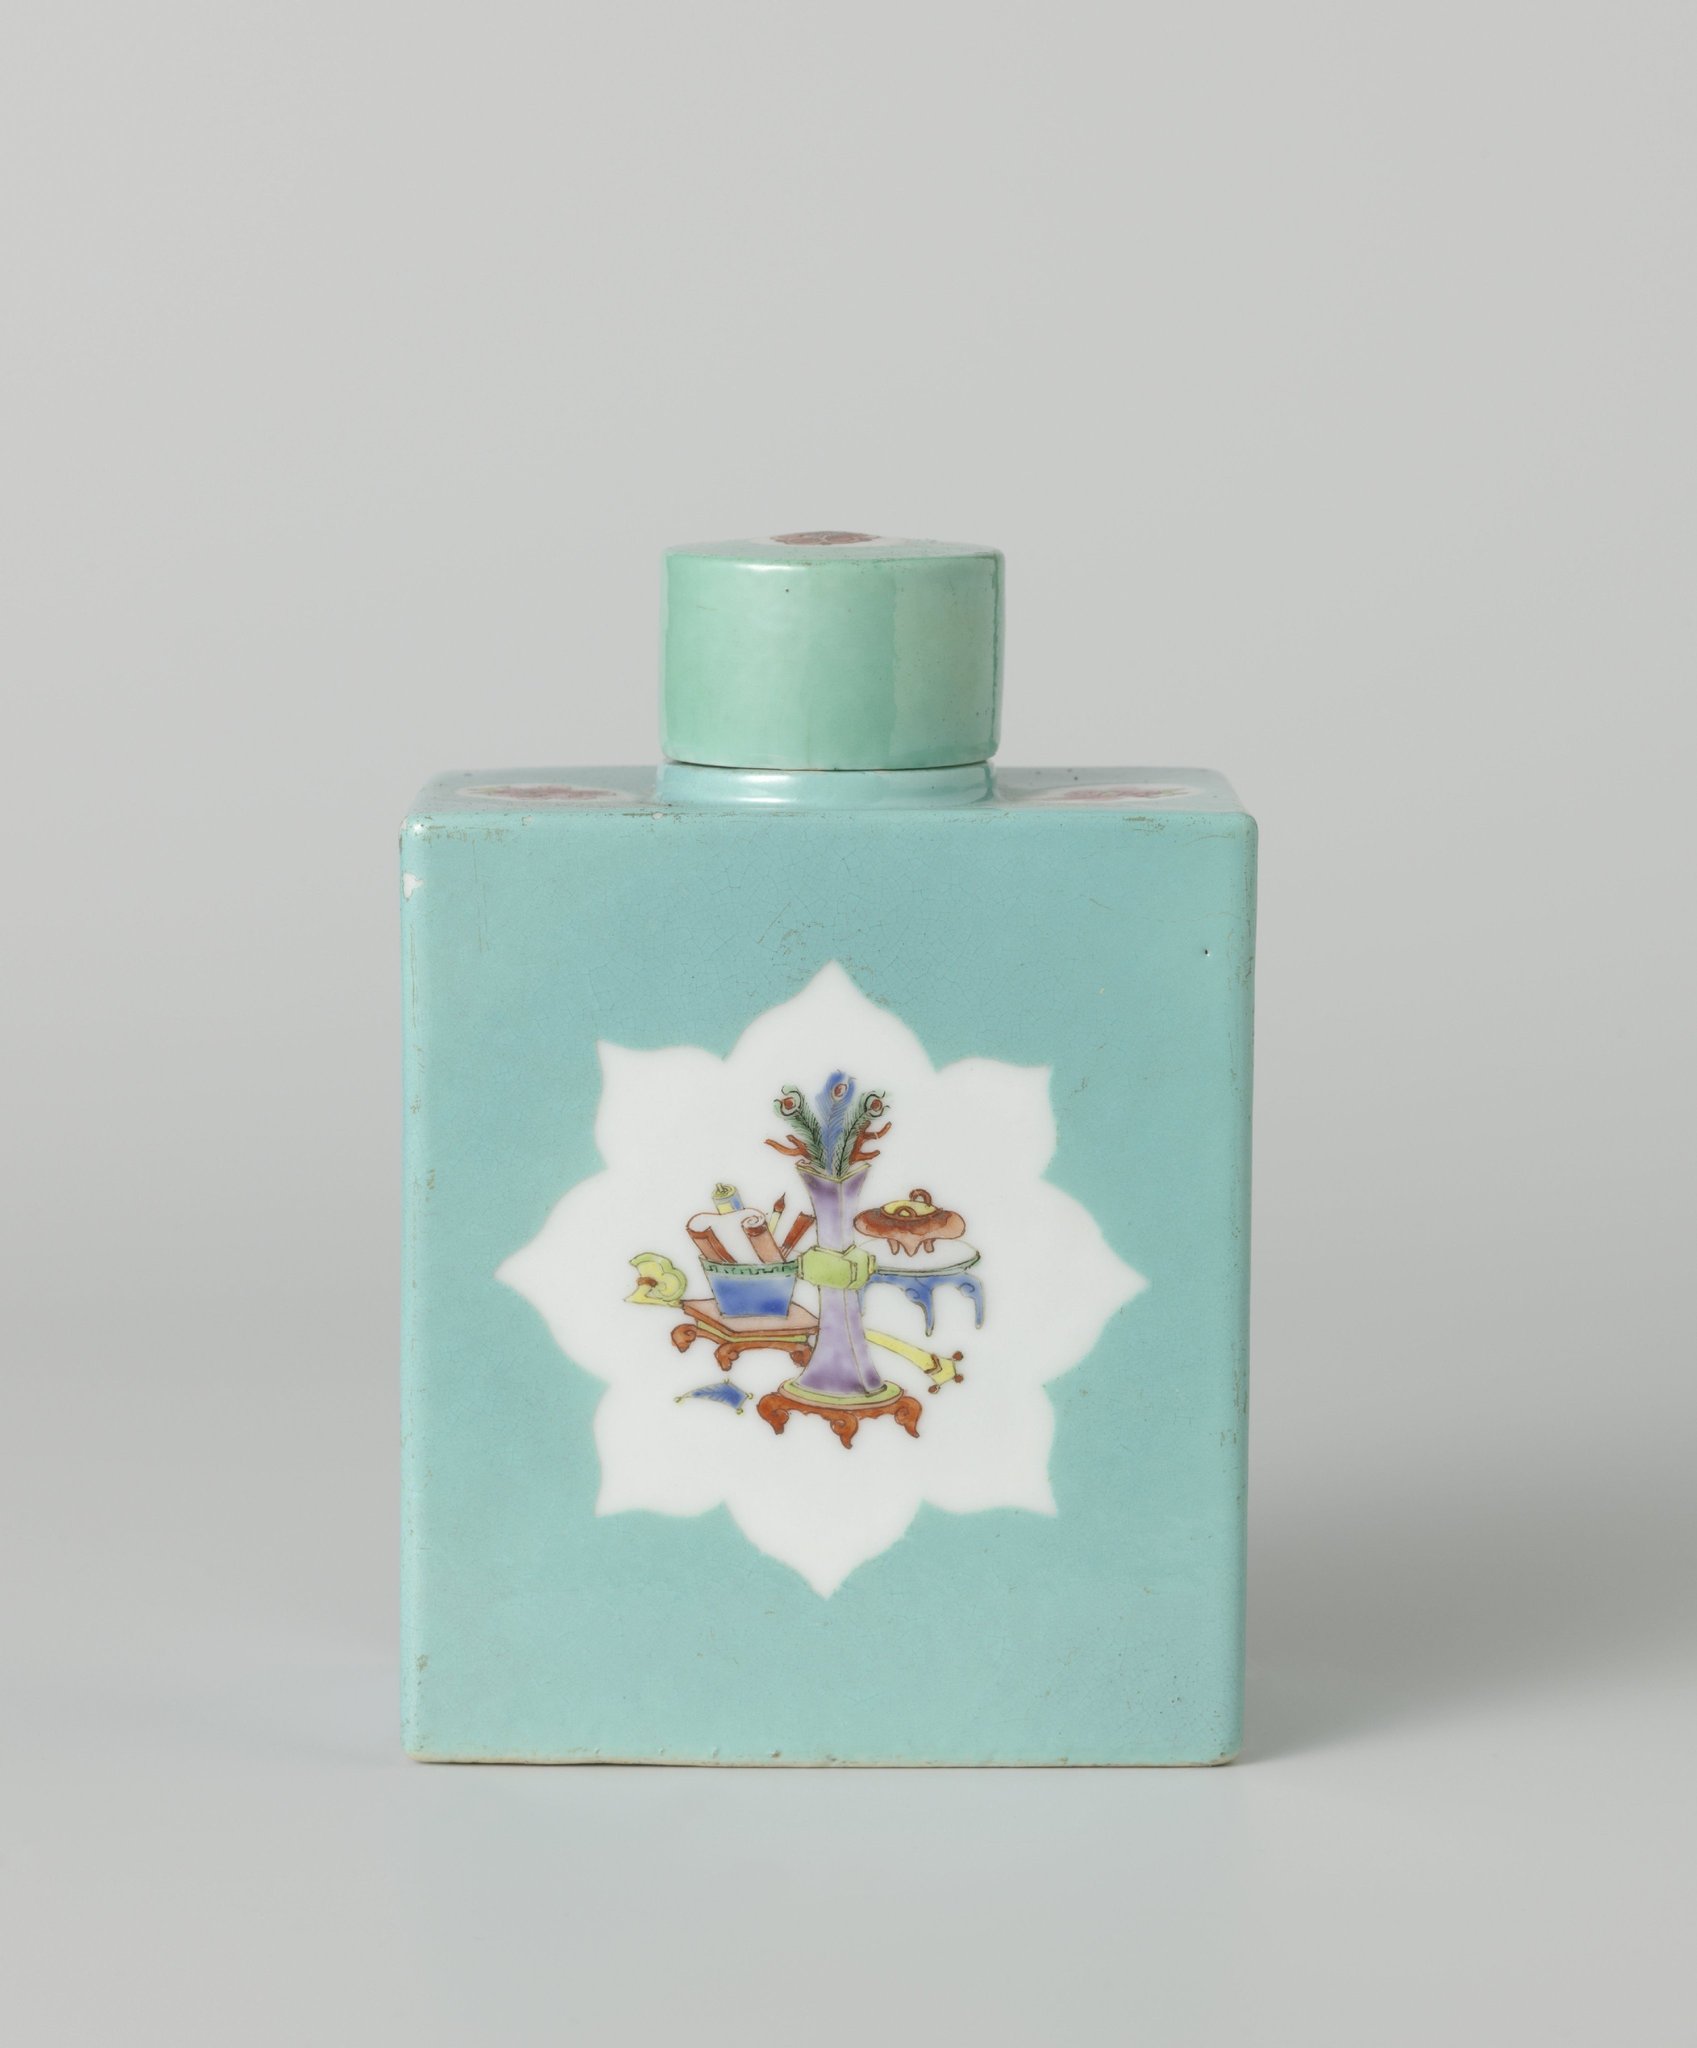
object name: tea caddy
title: Rectangular tea caddy covered with a light blue glaze and antiquities in panels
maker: Anonymous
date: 1760-1770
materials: glaze, paint, porcelain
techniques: firing, forming, turning, vitrification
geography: china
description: Rechthoekige theebus van porselein, bedekt met een lichtblauw/ turquoise glazuur en beschilderd op het glazuur in blauw, rood, groen, geel, paars en zwart. Op de brede zijdes een uitgespaard lotusvormig cartouche met antiquiteiten (vaas met pauwenveren en koraal, ruyi-scepter, boekrol, wierookbrander, etc.), de smalle zijdes met bloeiende plant (Chinese anjer of ballonklokje) in uitgespaard, bladvormig cartouche; op de schouder twee uitgespaarde medaillons met pioenroos. Europese vormen met emailkleuren.